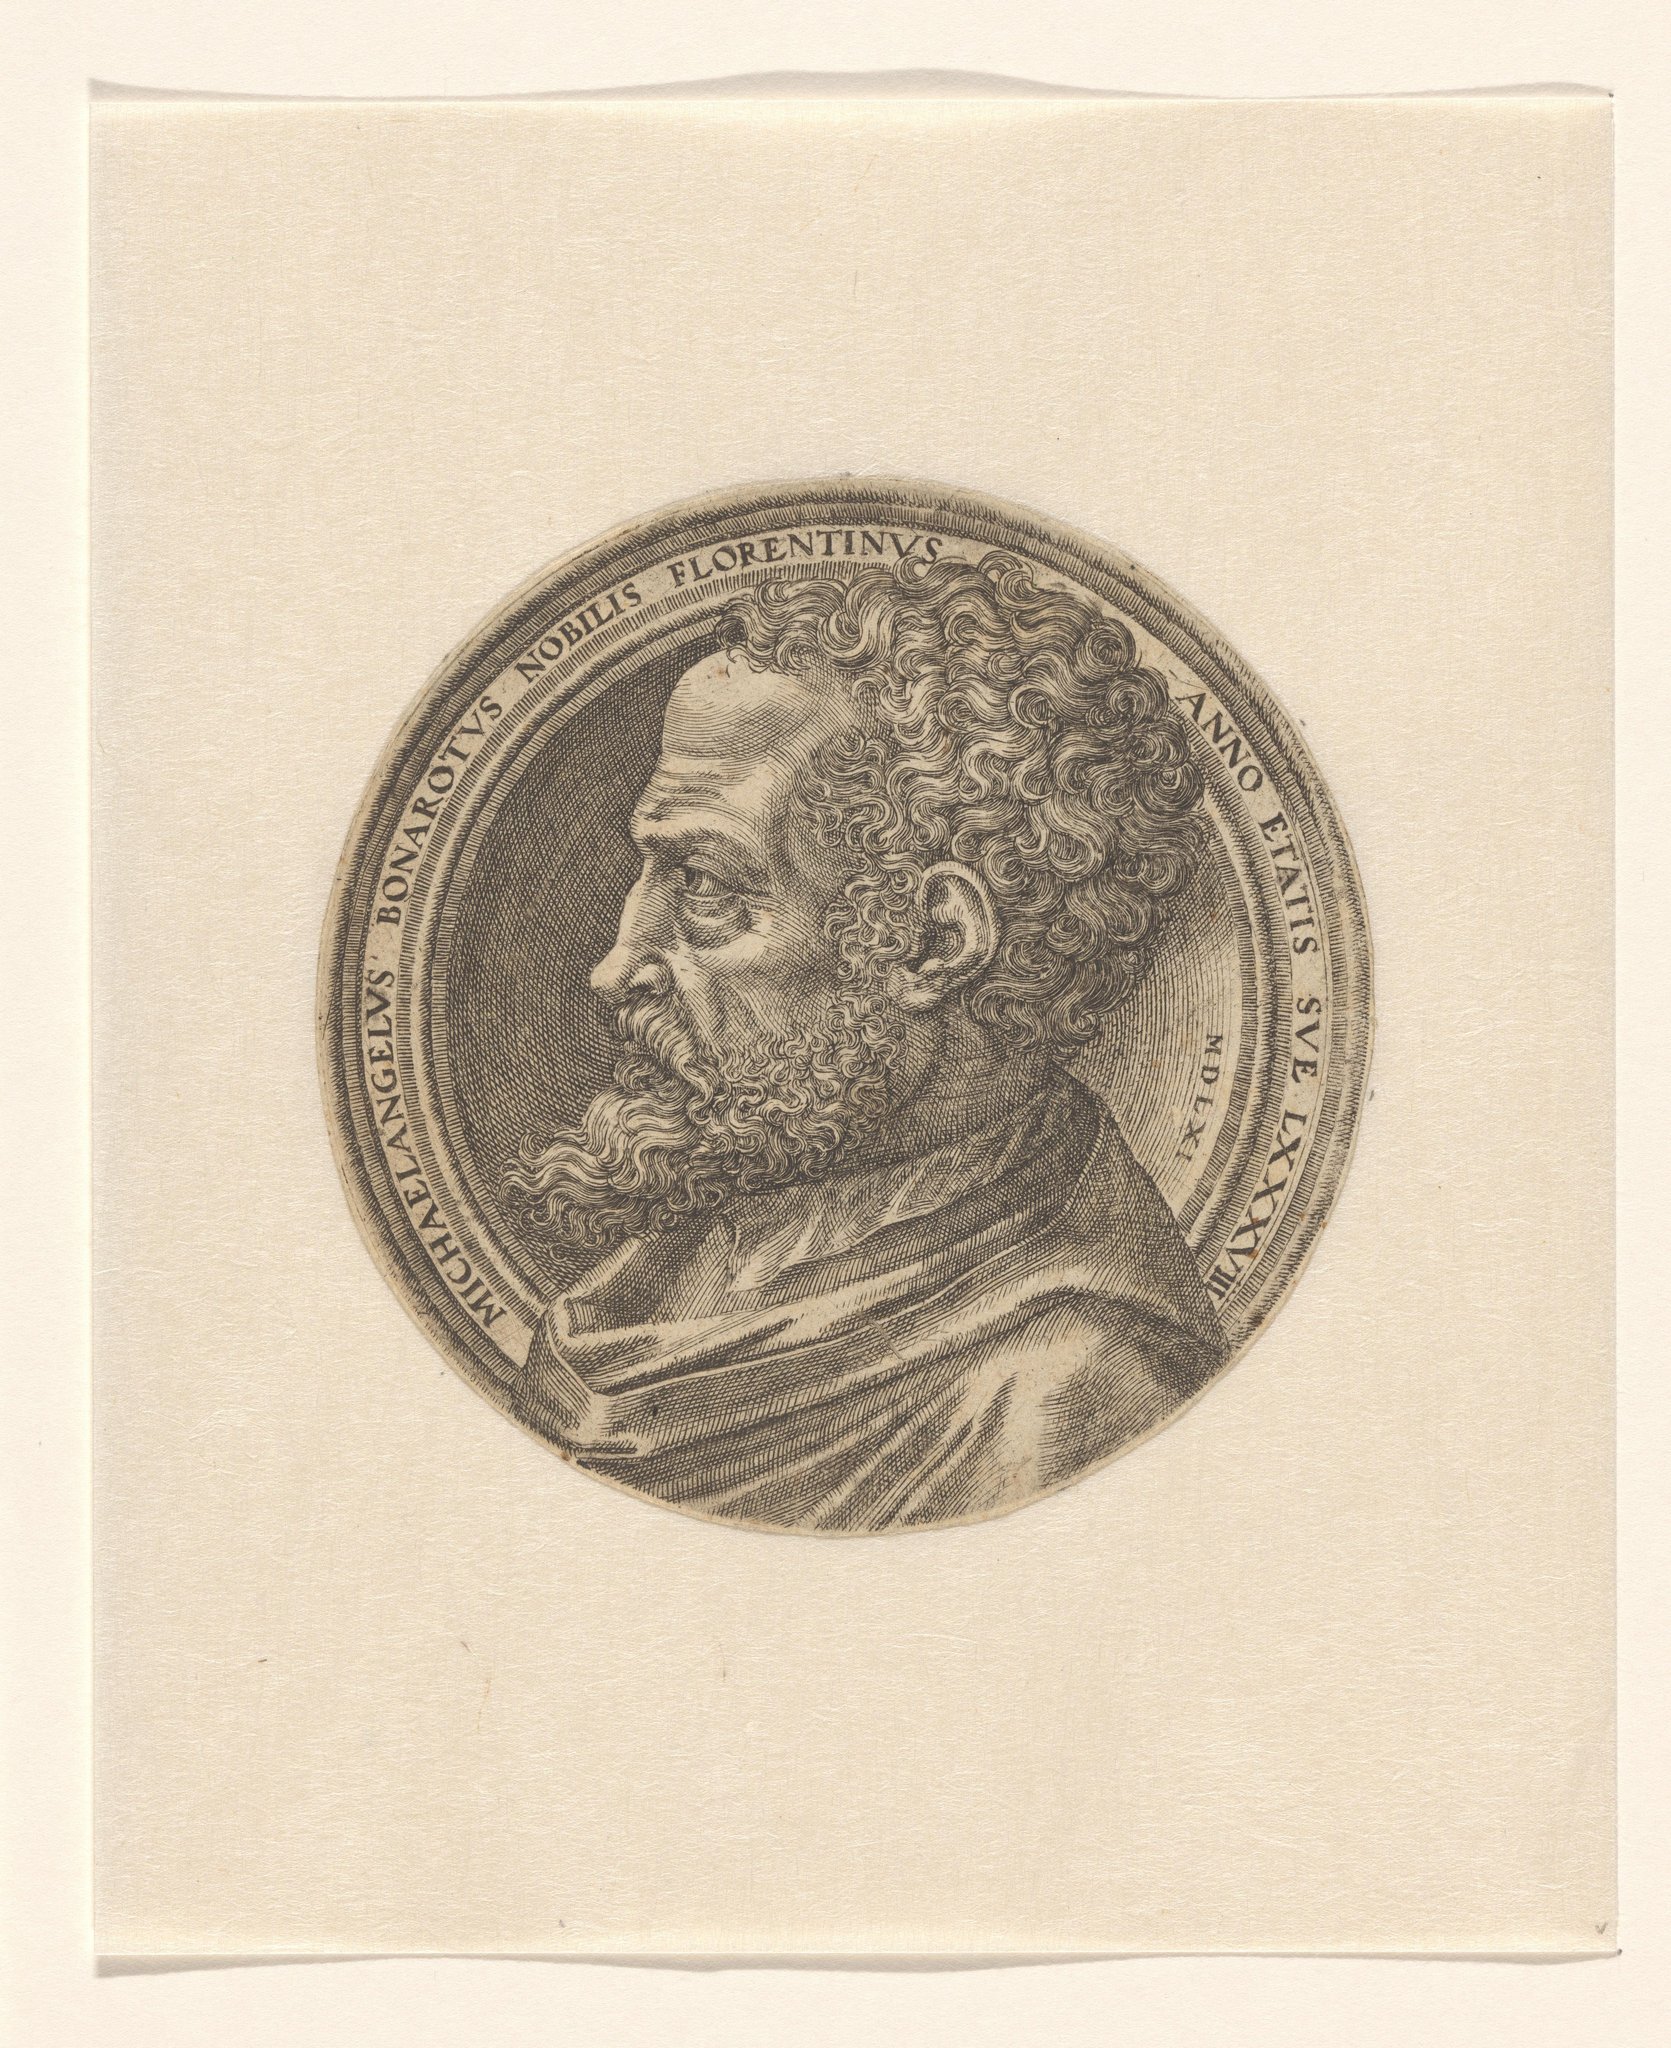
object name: print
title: Portret van Michelangelo en profil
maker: lambertus suavius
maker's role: print maker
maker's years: 1514-1564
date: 1561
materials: ink, paper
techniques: engraving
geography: venice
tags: rome, painter, draughtsman, sculptor, michelangelo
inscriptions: date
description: Portret van Michelangelo Buanarroti. Spiegelbeeldige kopie naar de medaillon gemaakt ter gelegenheid van de 88ste verjaardag van de kunstenaar door Leone Leoni.